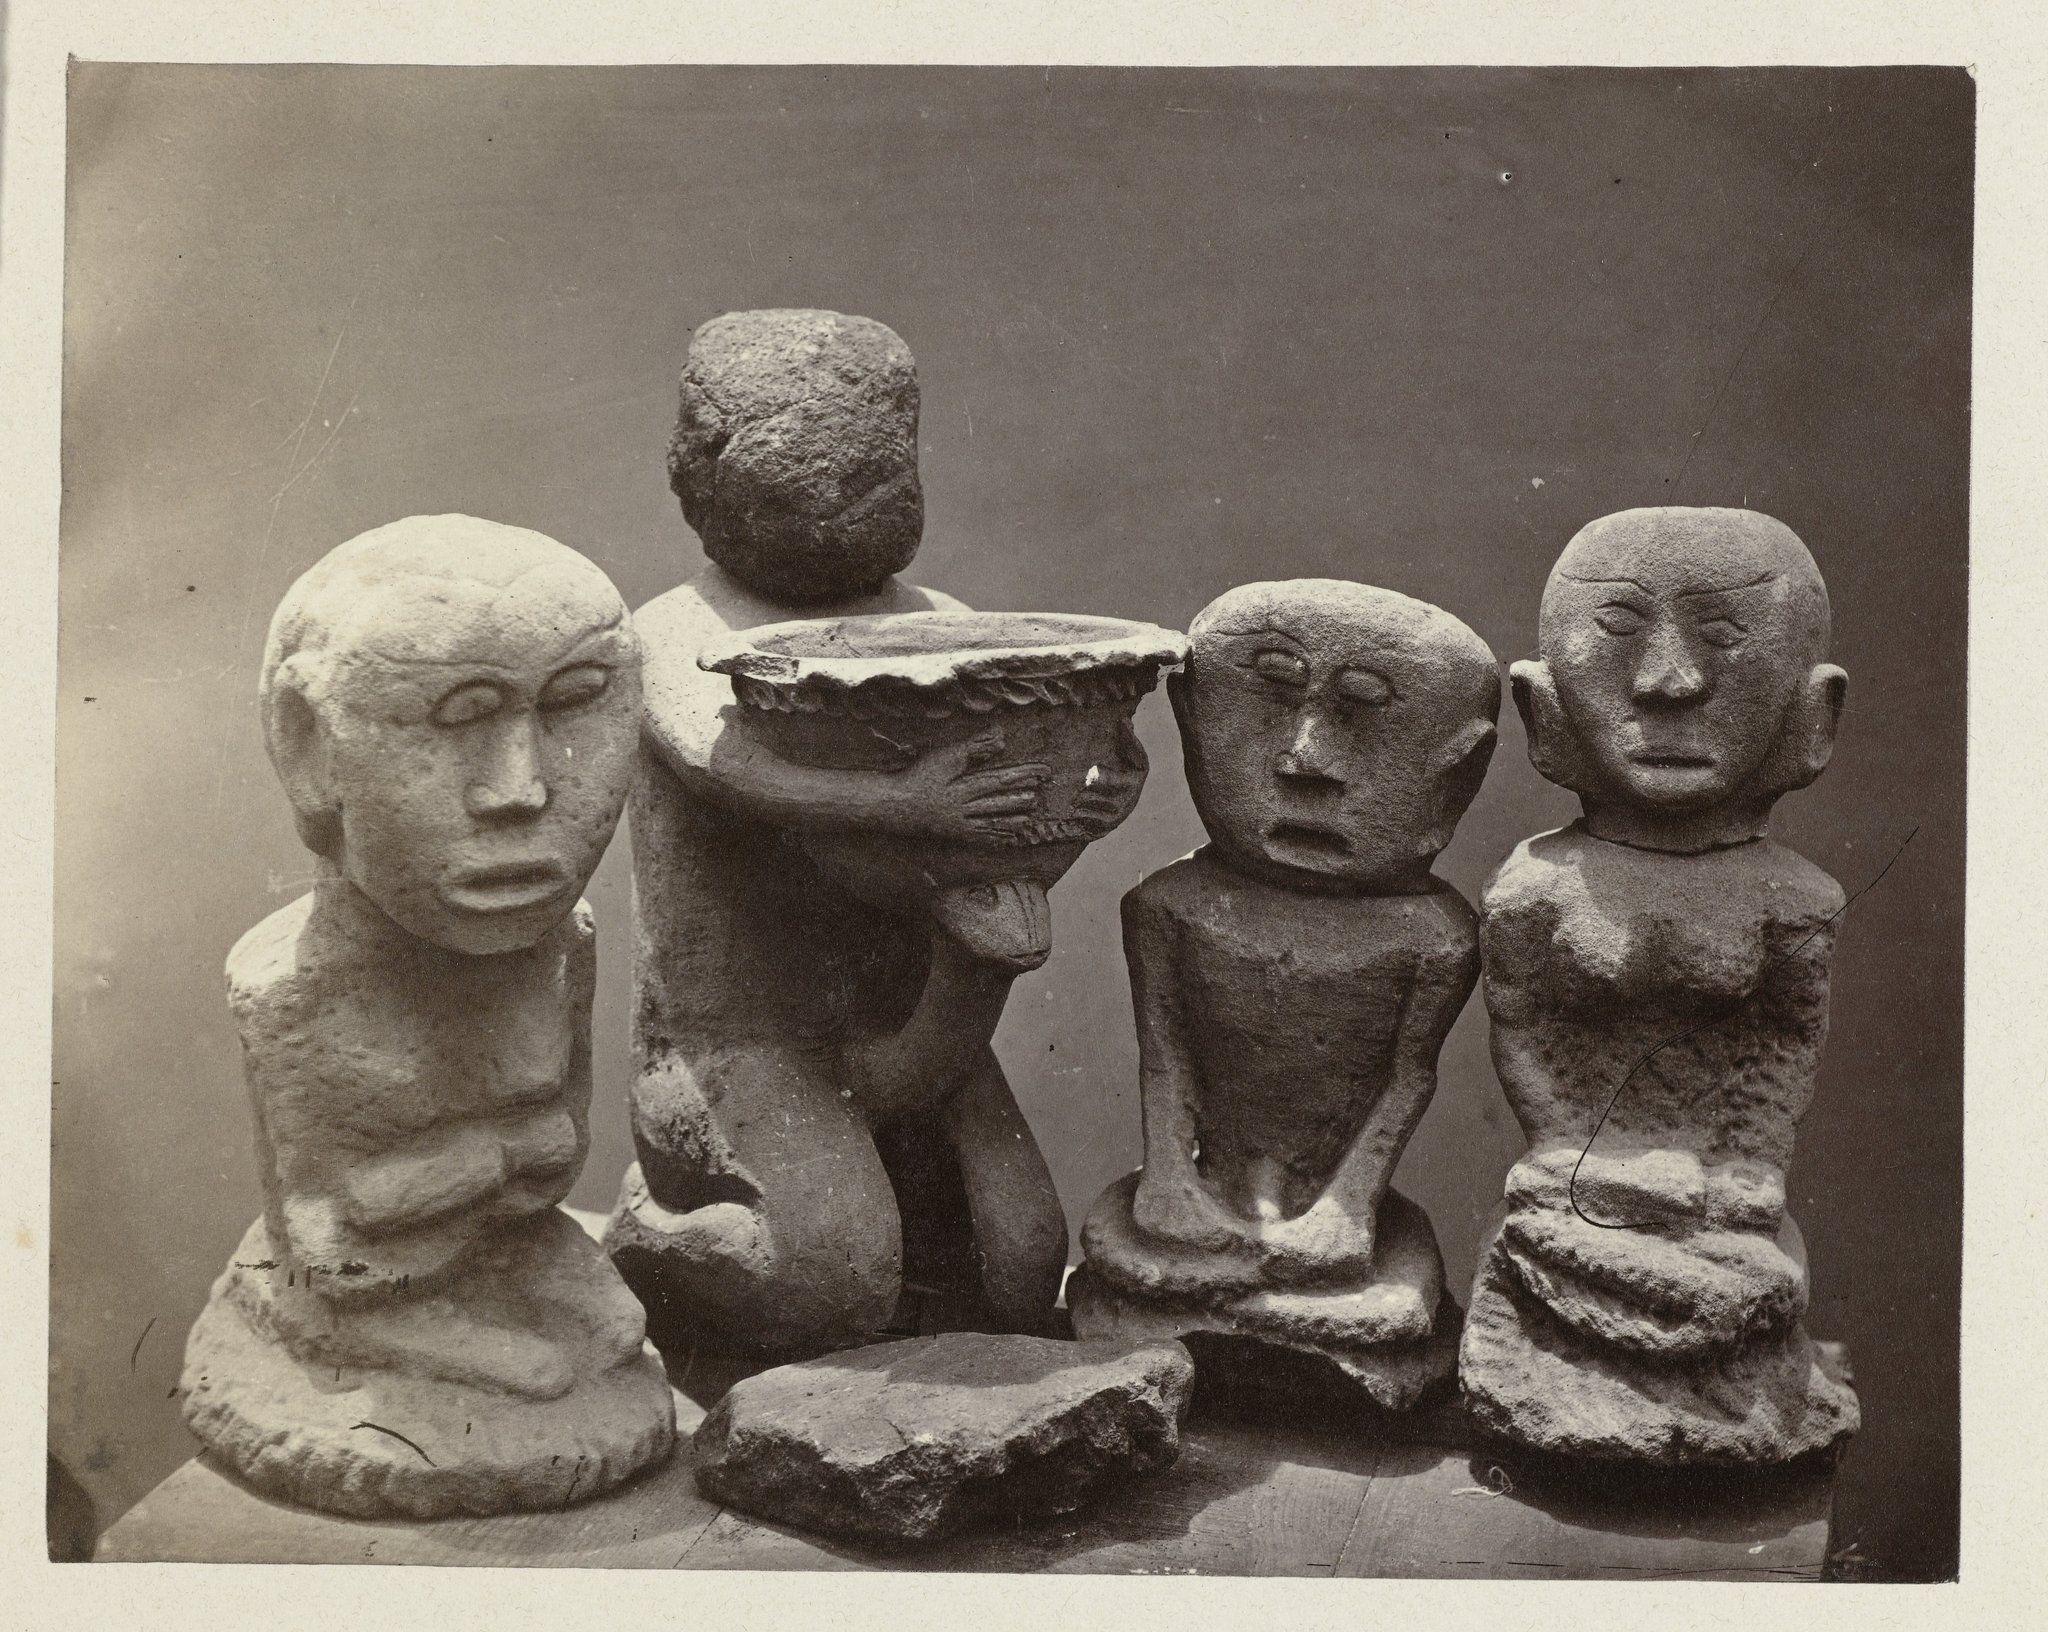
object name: photograph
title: Terra cotta group holding two itiphallic figures and two female figures with child. Karta Wangungan, Kuningan district, West Java province,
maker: isidore kinsbergen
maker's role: fotograaf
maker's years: 1821-1905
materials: cardboard, paper, photographic support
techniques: albumen print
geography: java